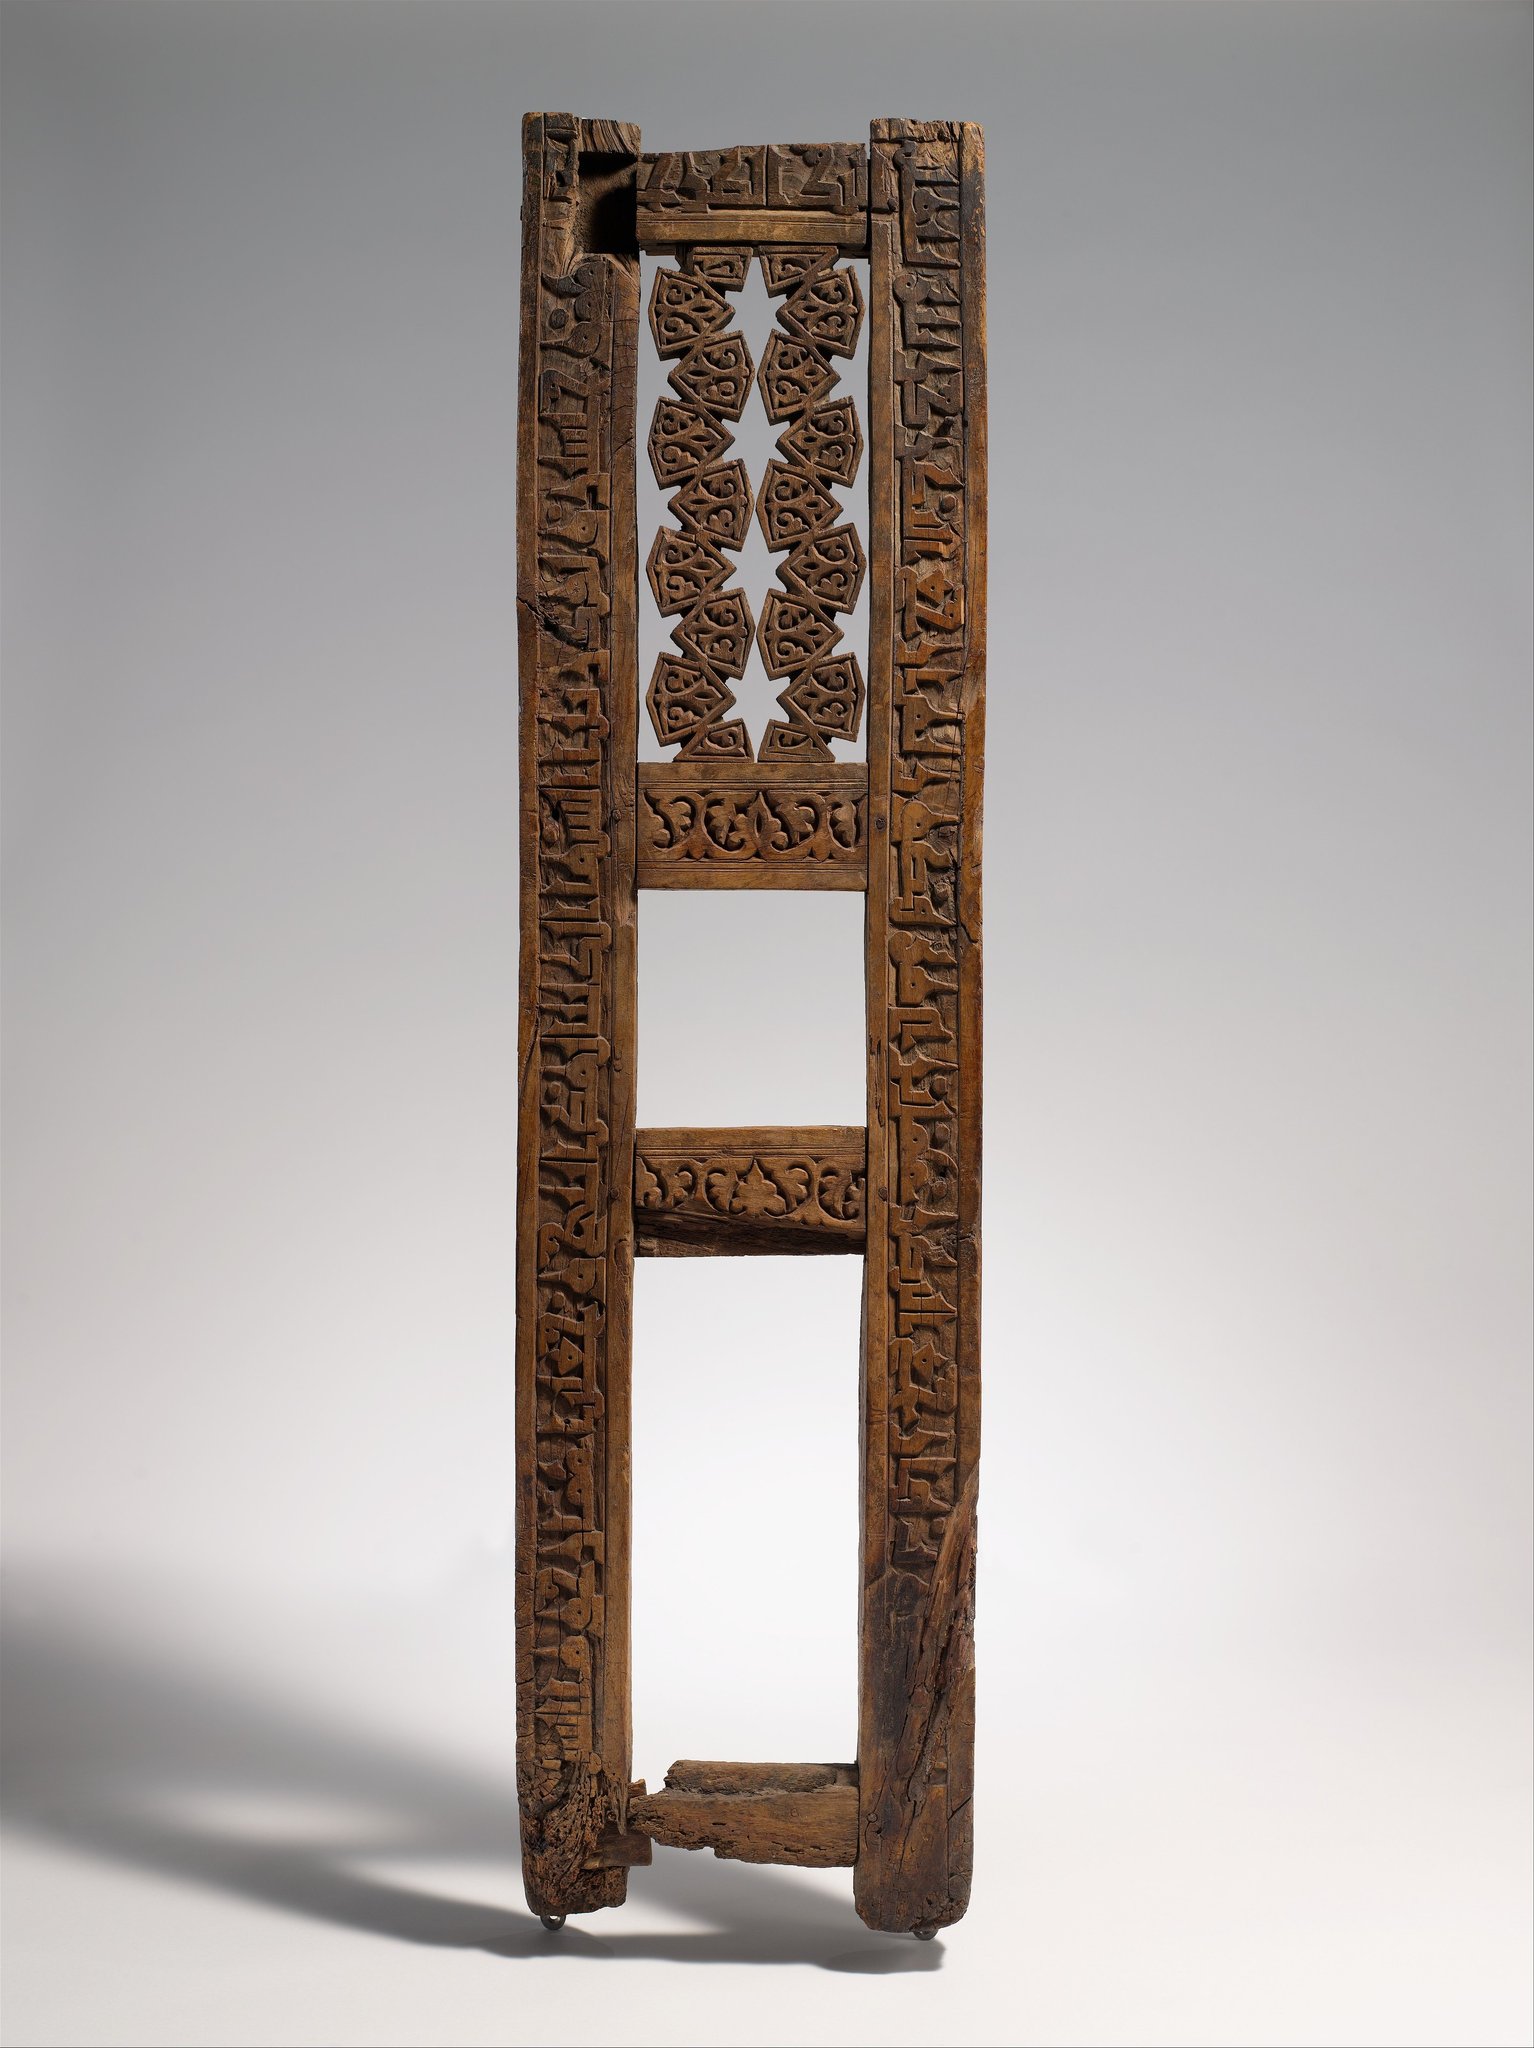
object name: fragment of a pulpit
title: Fragment of a Pulpit (Minbar)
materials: wood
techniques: carving, painting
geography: iran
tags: arabic